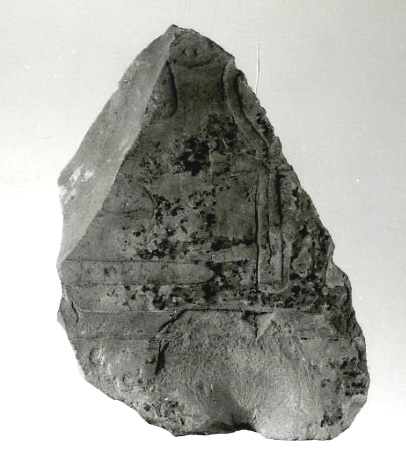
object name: relief fragment, tomb of meketre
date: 1981-1975 BCE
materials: limestone, paint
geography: egypt